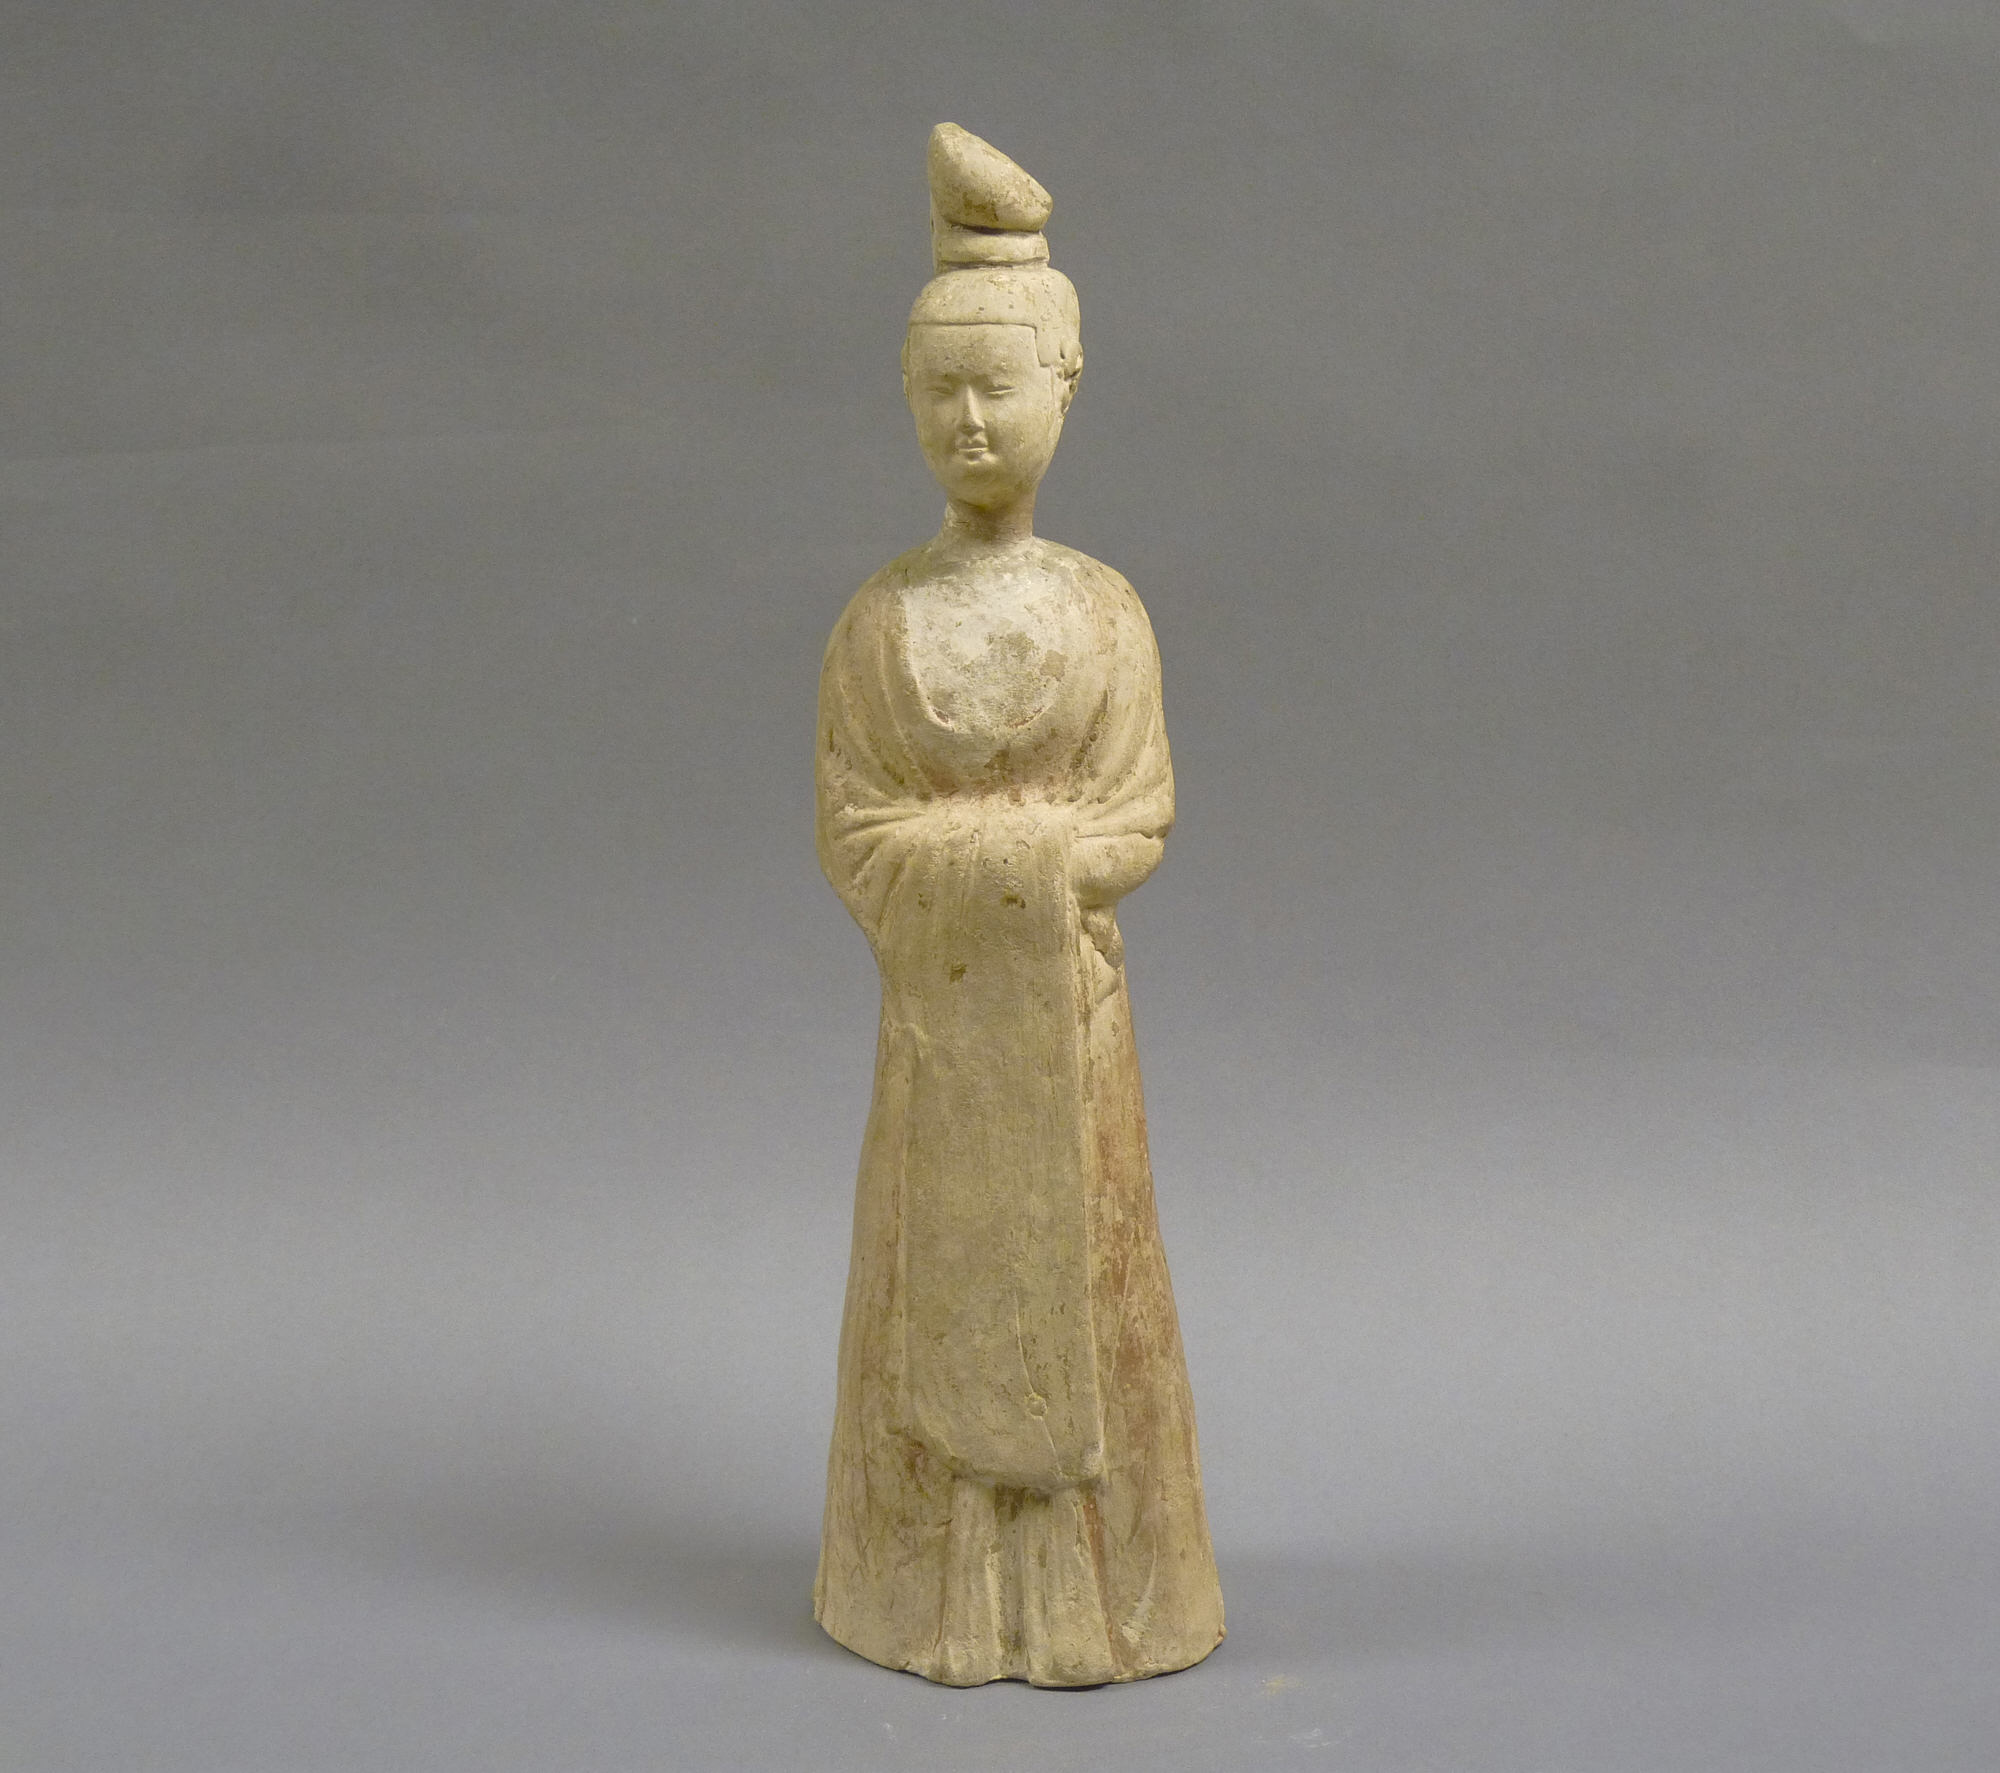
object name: figure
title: Figures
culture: chinese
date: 601-800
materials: pottery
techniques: polychrome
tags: women